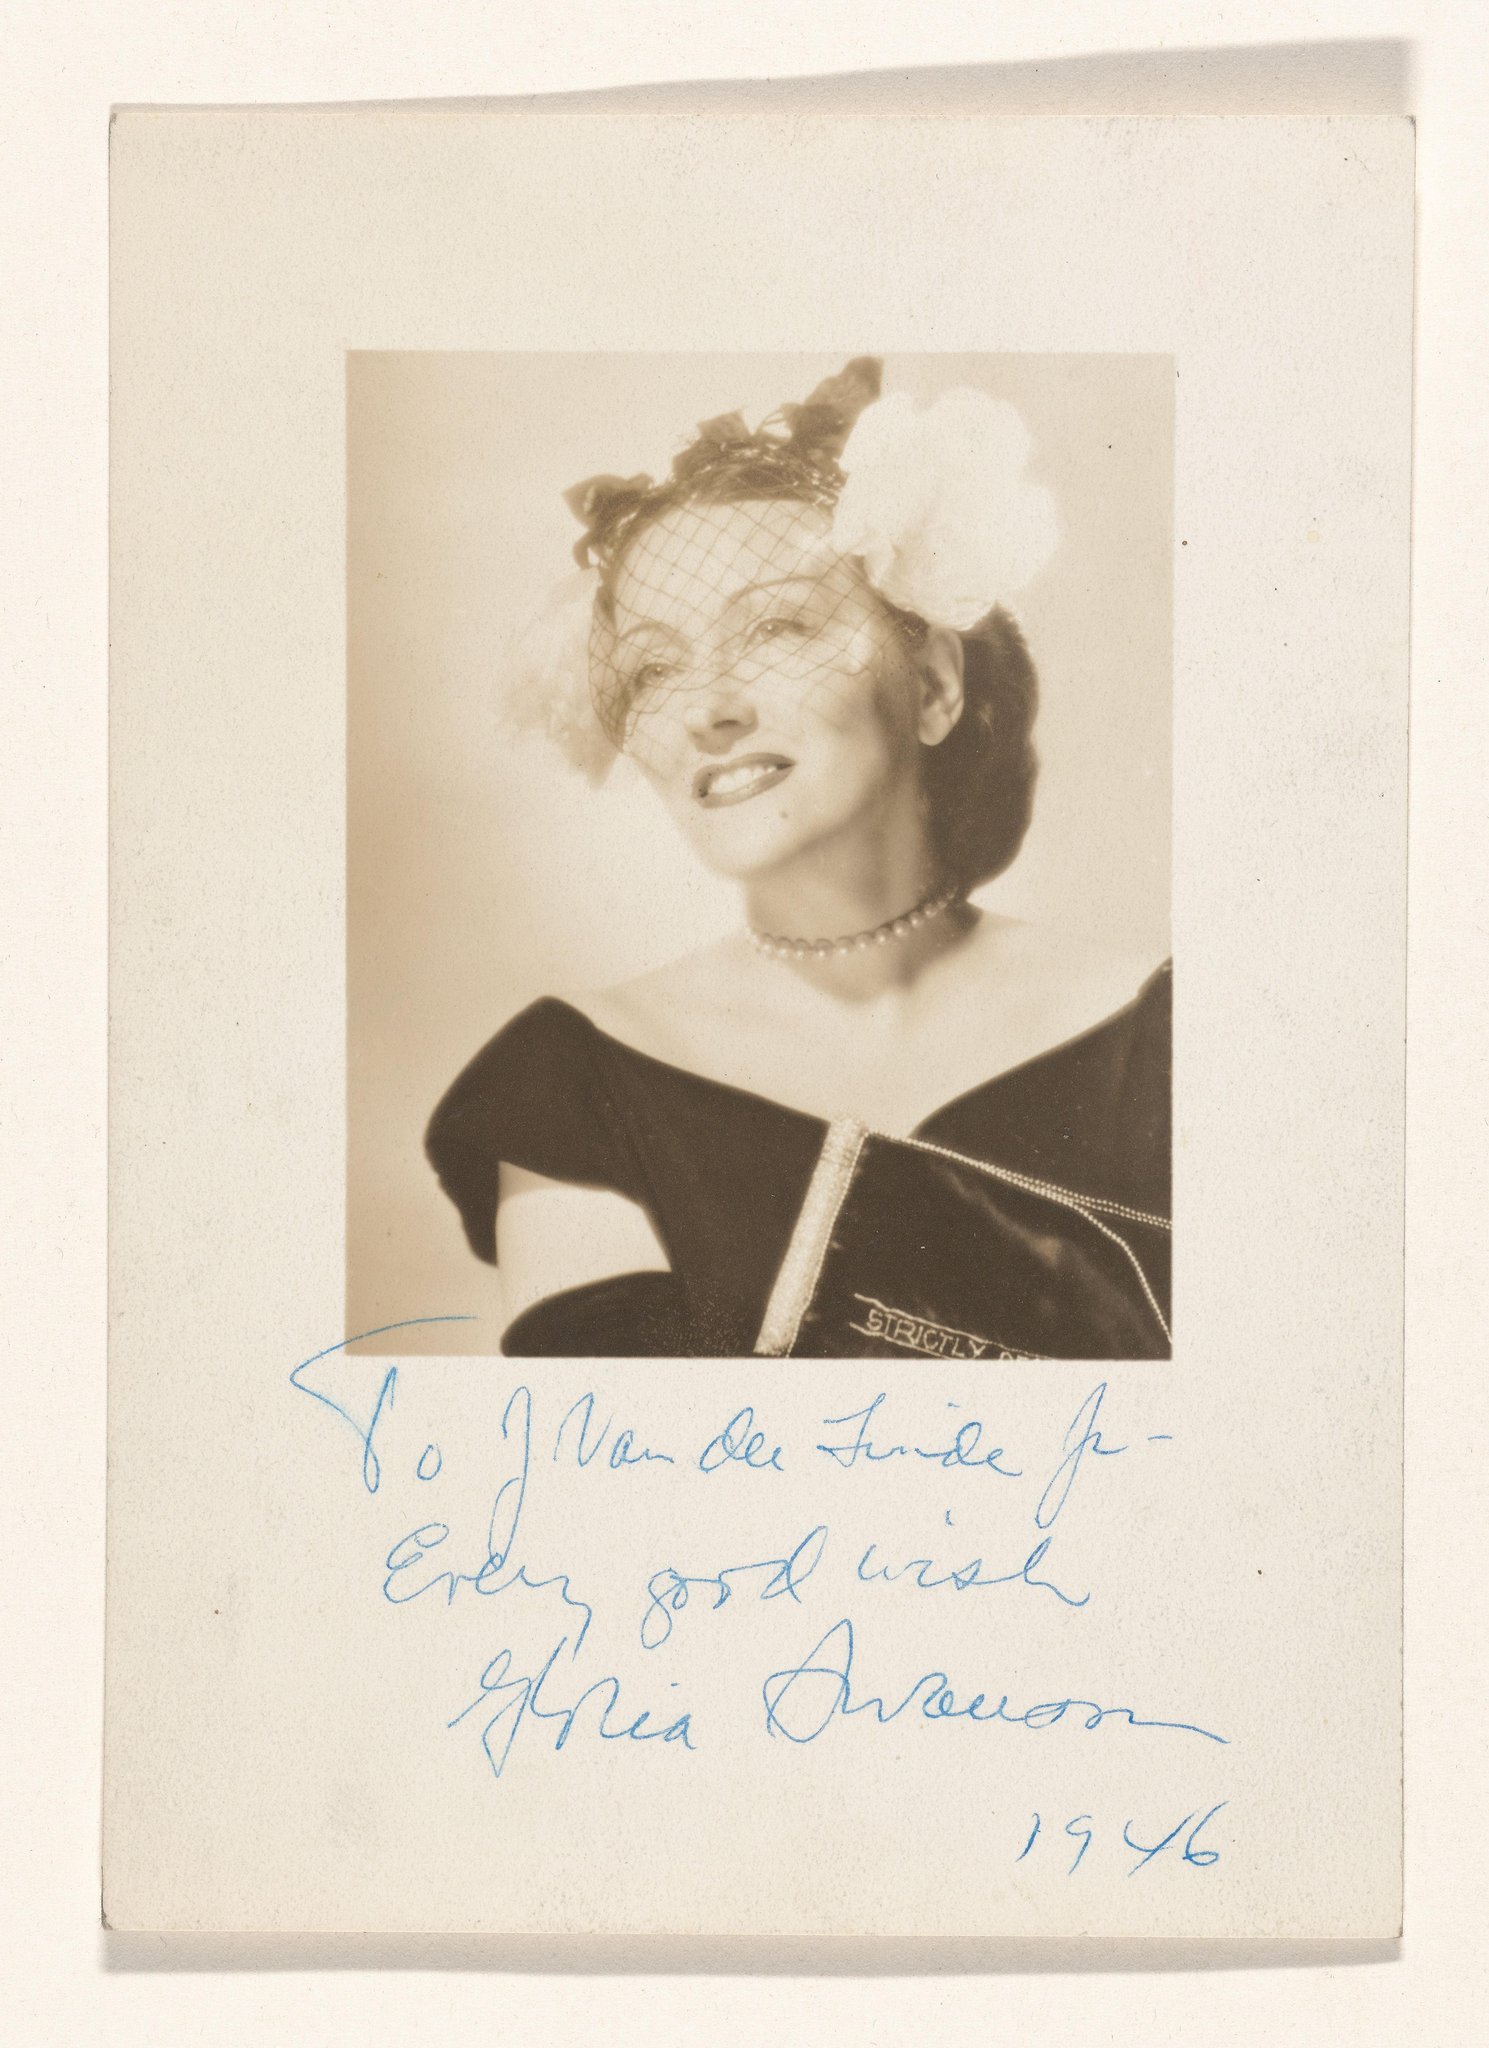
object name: photograph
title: To J. van der Linde Jr every good wish, Gloria Swanson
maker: Anonymous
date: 1929-1946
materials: photographic support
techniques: gelatin silver print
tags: historical persons - bb - woman, portrait of film actor, film actress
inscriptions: inscription: ‘Gloria Swanson, Queen Kelly 1929... Madame sans gene’